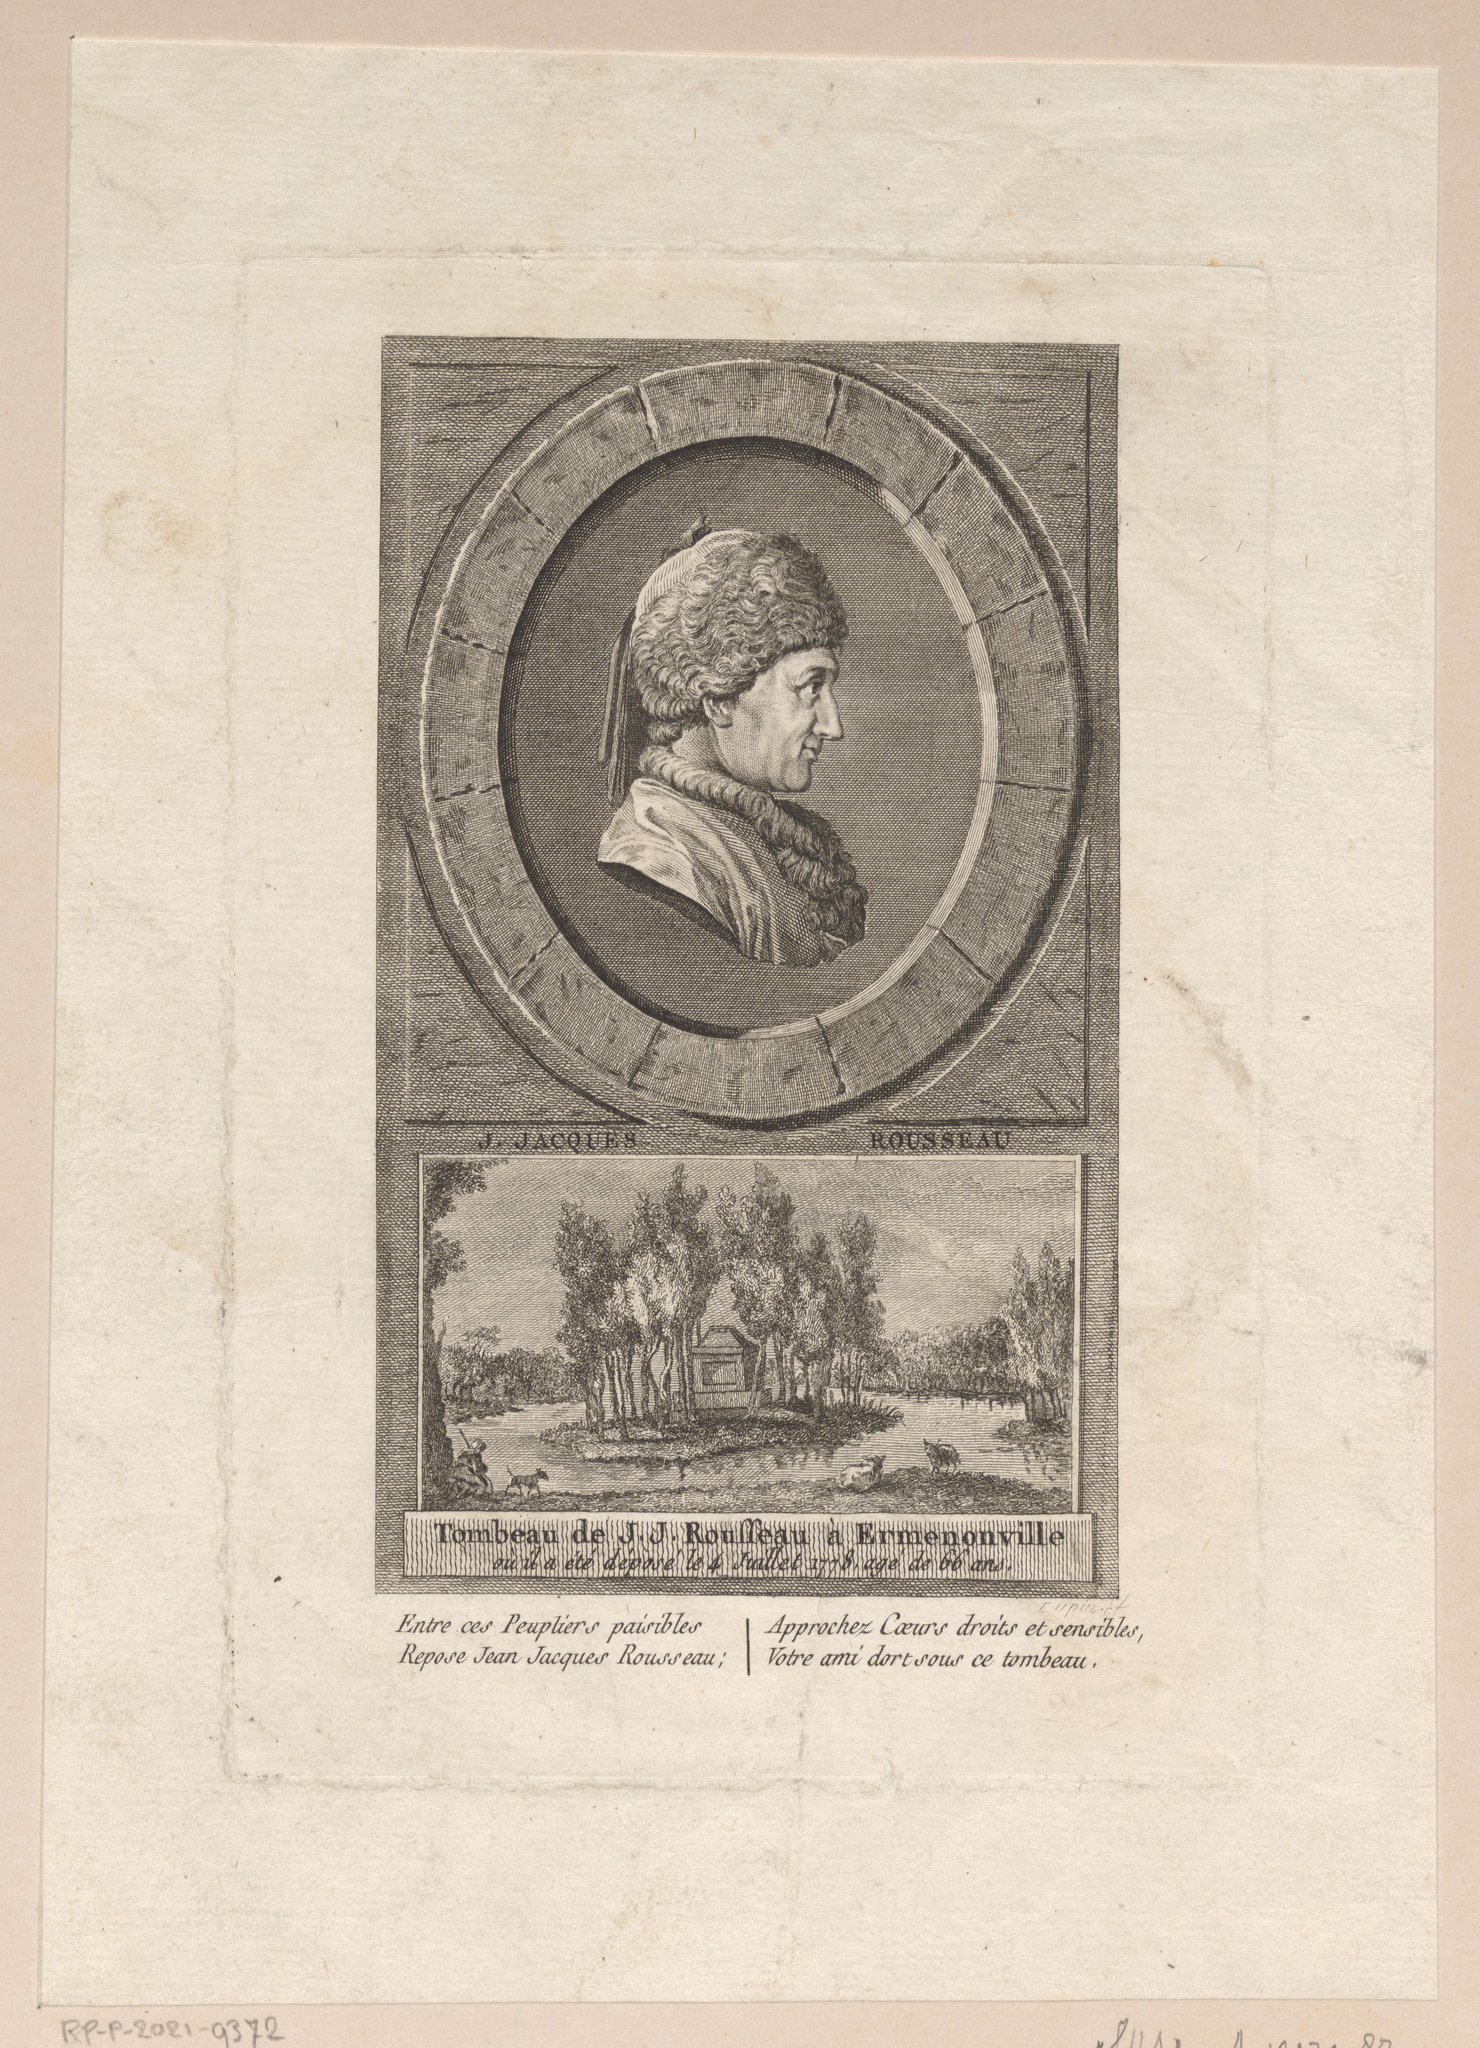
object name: print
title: Portret van Jean-Jacques Rousseau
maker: Anonymous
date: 1778-1799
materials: paper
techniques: engraving, etching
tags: historical persons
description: Onder het portret de graftombe van Rousseau. Onder de tombe een vierregelig vers.